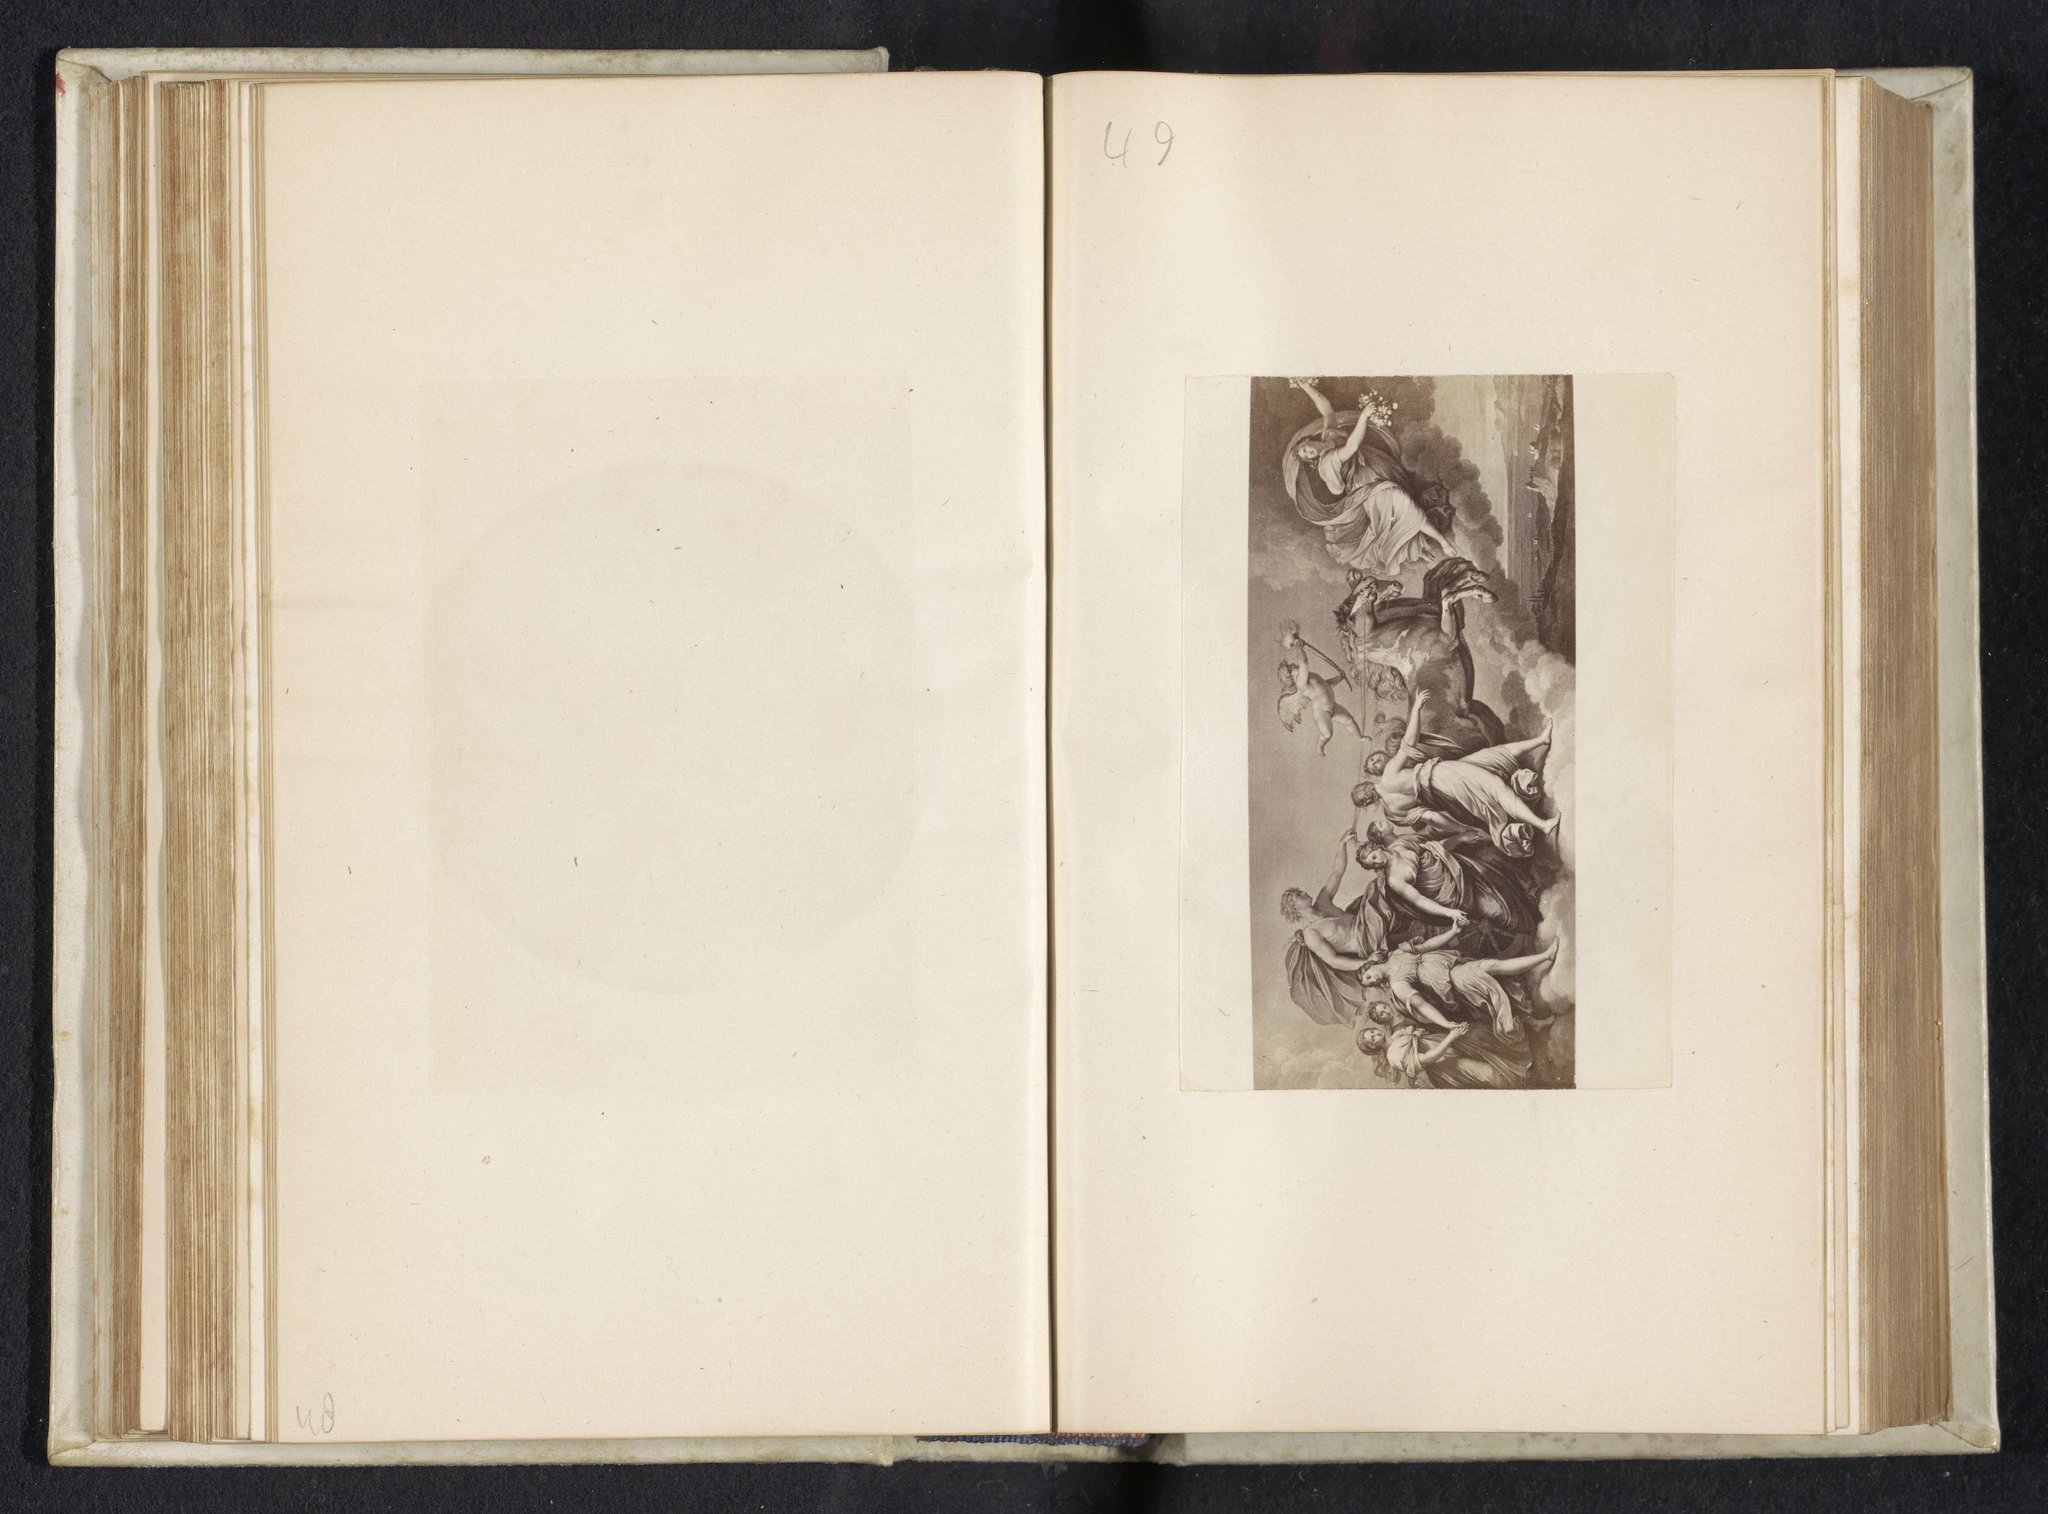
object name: reproduction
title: Fotoreproductie van een schilderij, voorstellende de triomf van (vermoedelijk) Amor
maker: Anonymous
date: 1850-1860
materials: photographic support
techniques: albumen print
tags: 'trionfi d'amore', 'triumphus cupidinis'; 'carro d'amore' (ripa)